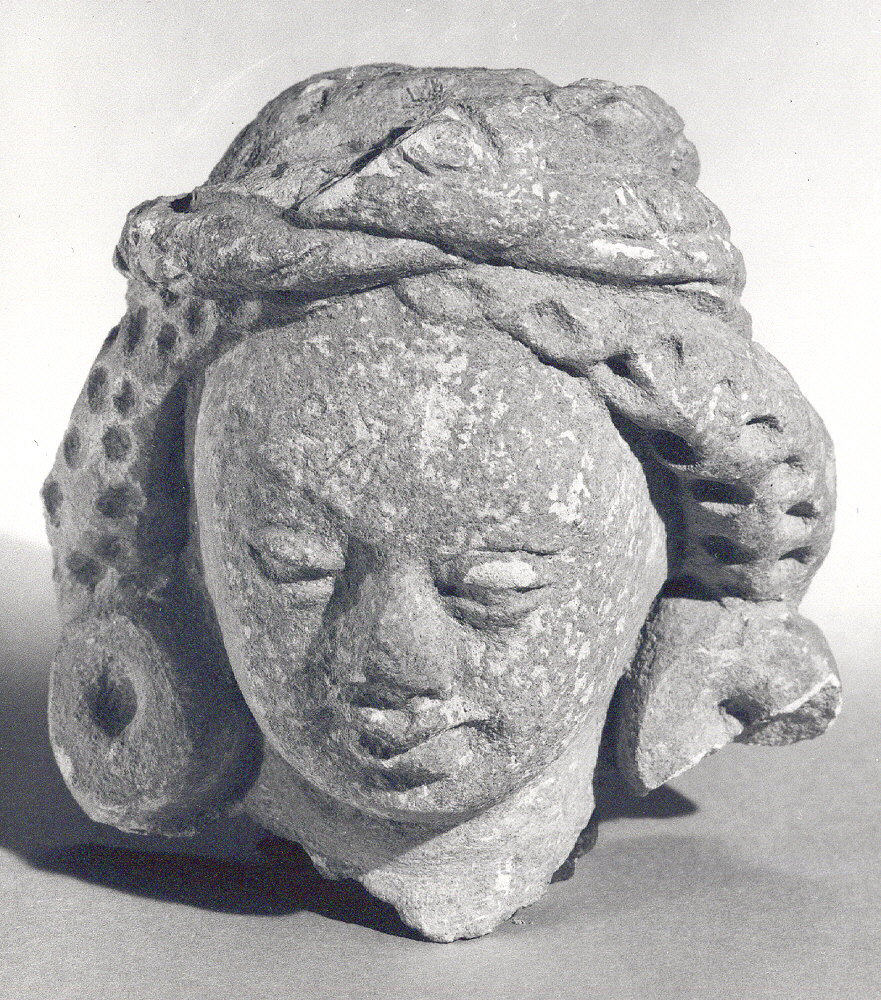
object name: head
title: Head of a Male Figure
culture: afghan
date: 101-400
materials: plaster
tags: gandharan,heads,men